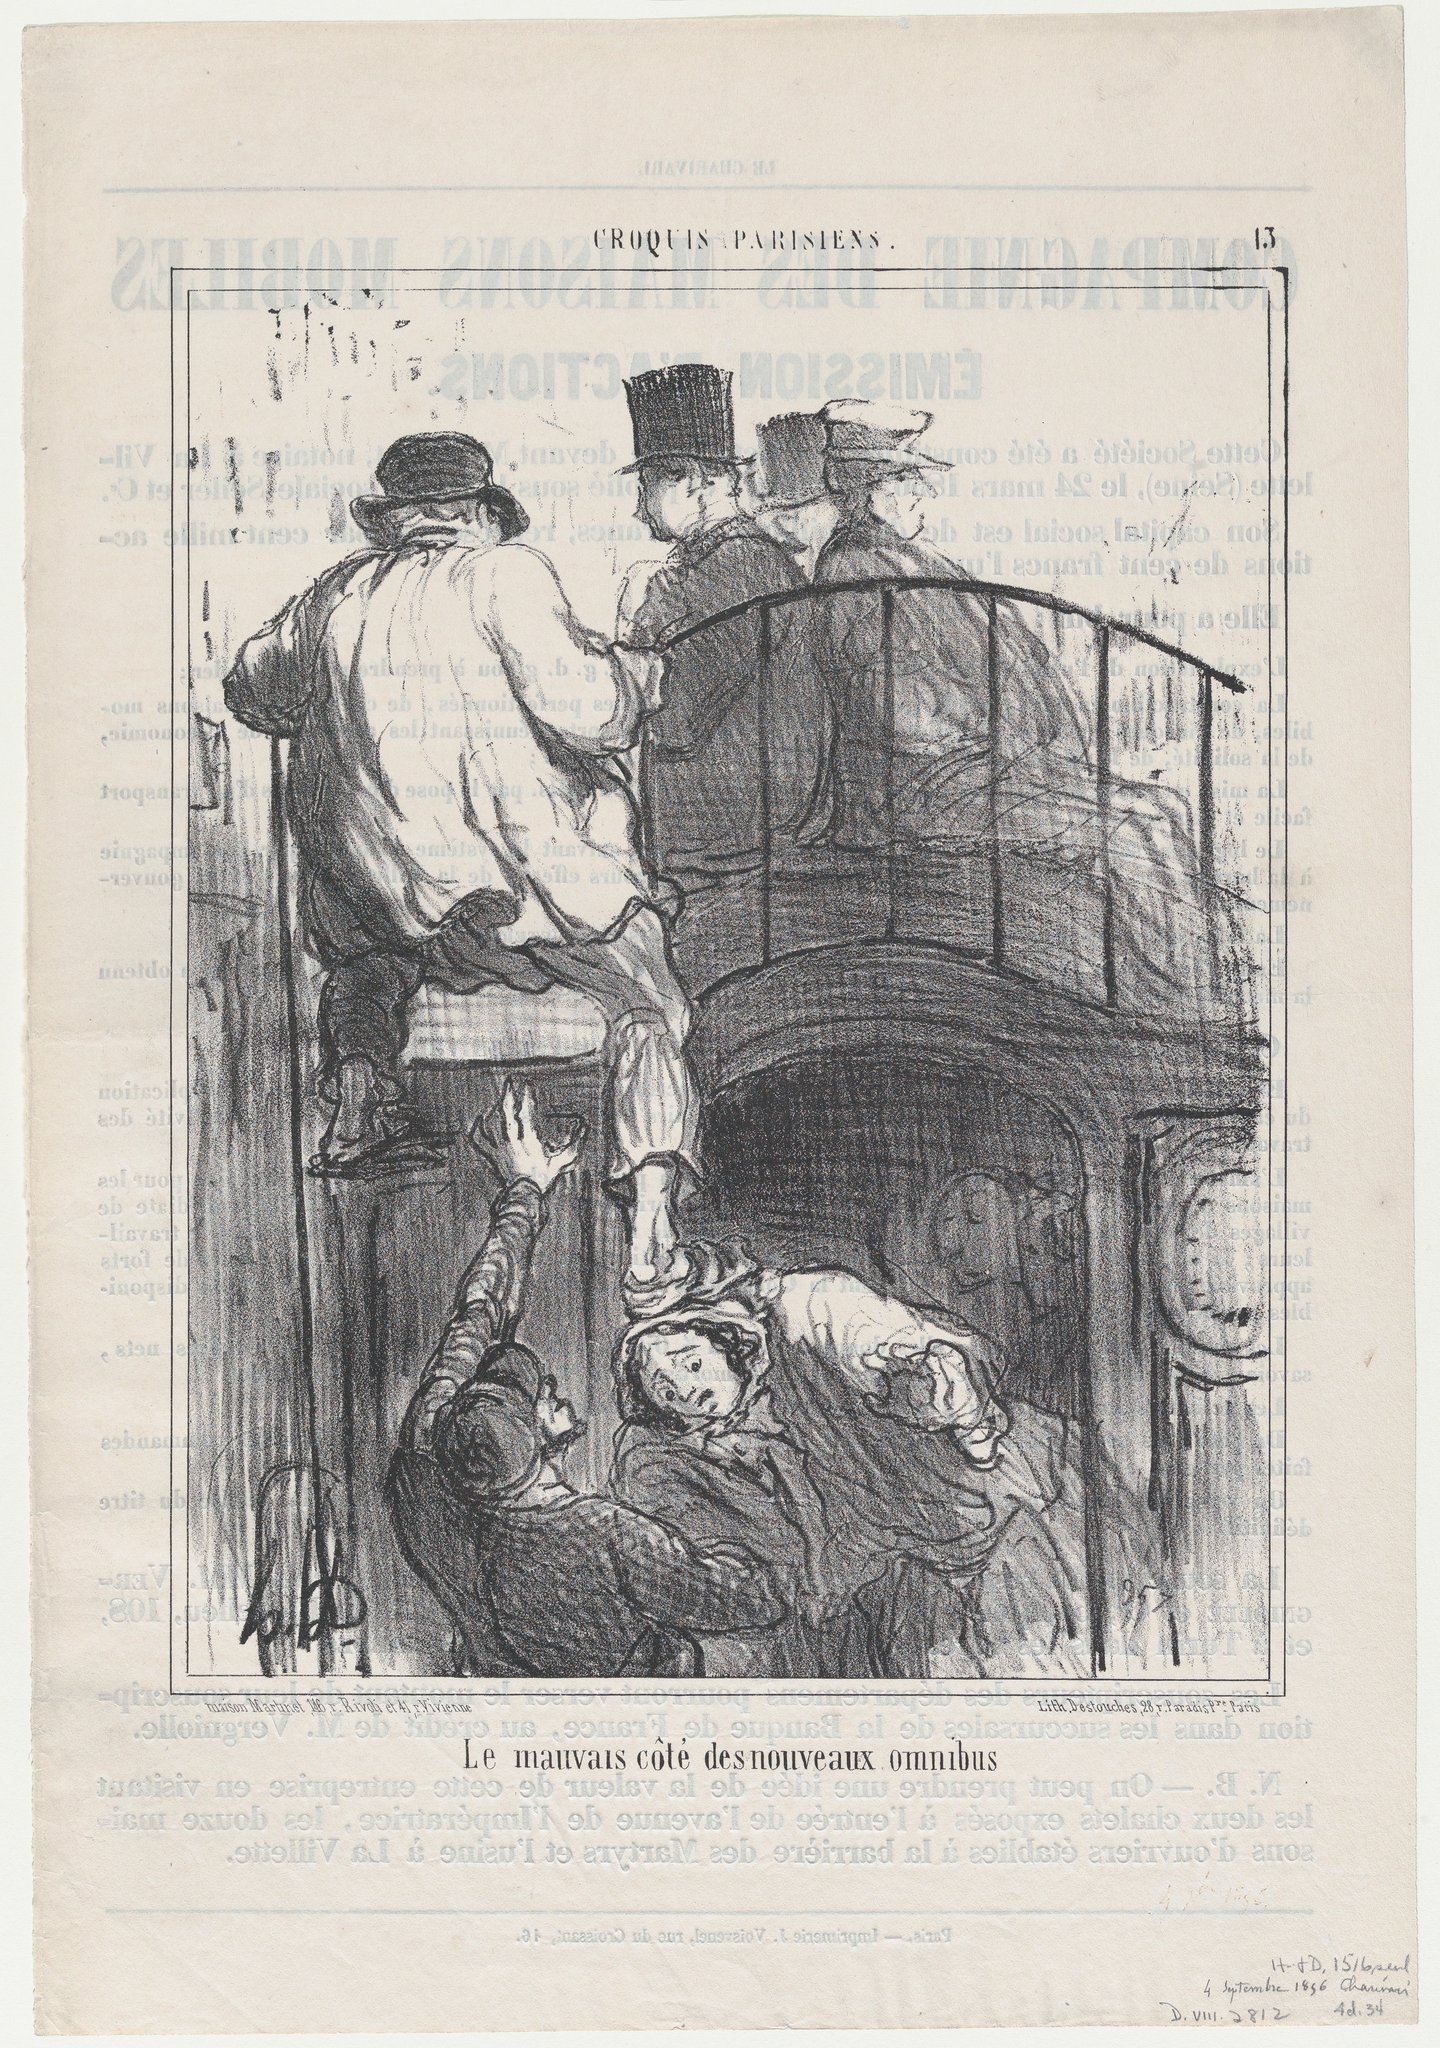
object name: print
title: Le mauvais côté des nouveaux omnibus, from Croquis Parisiens, published in Le Charivari, September 4, 1856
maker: honoré daumier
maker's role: artist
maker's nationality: french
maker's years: 1808-1879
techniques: lithograph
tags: men,women